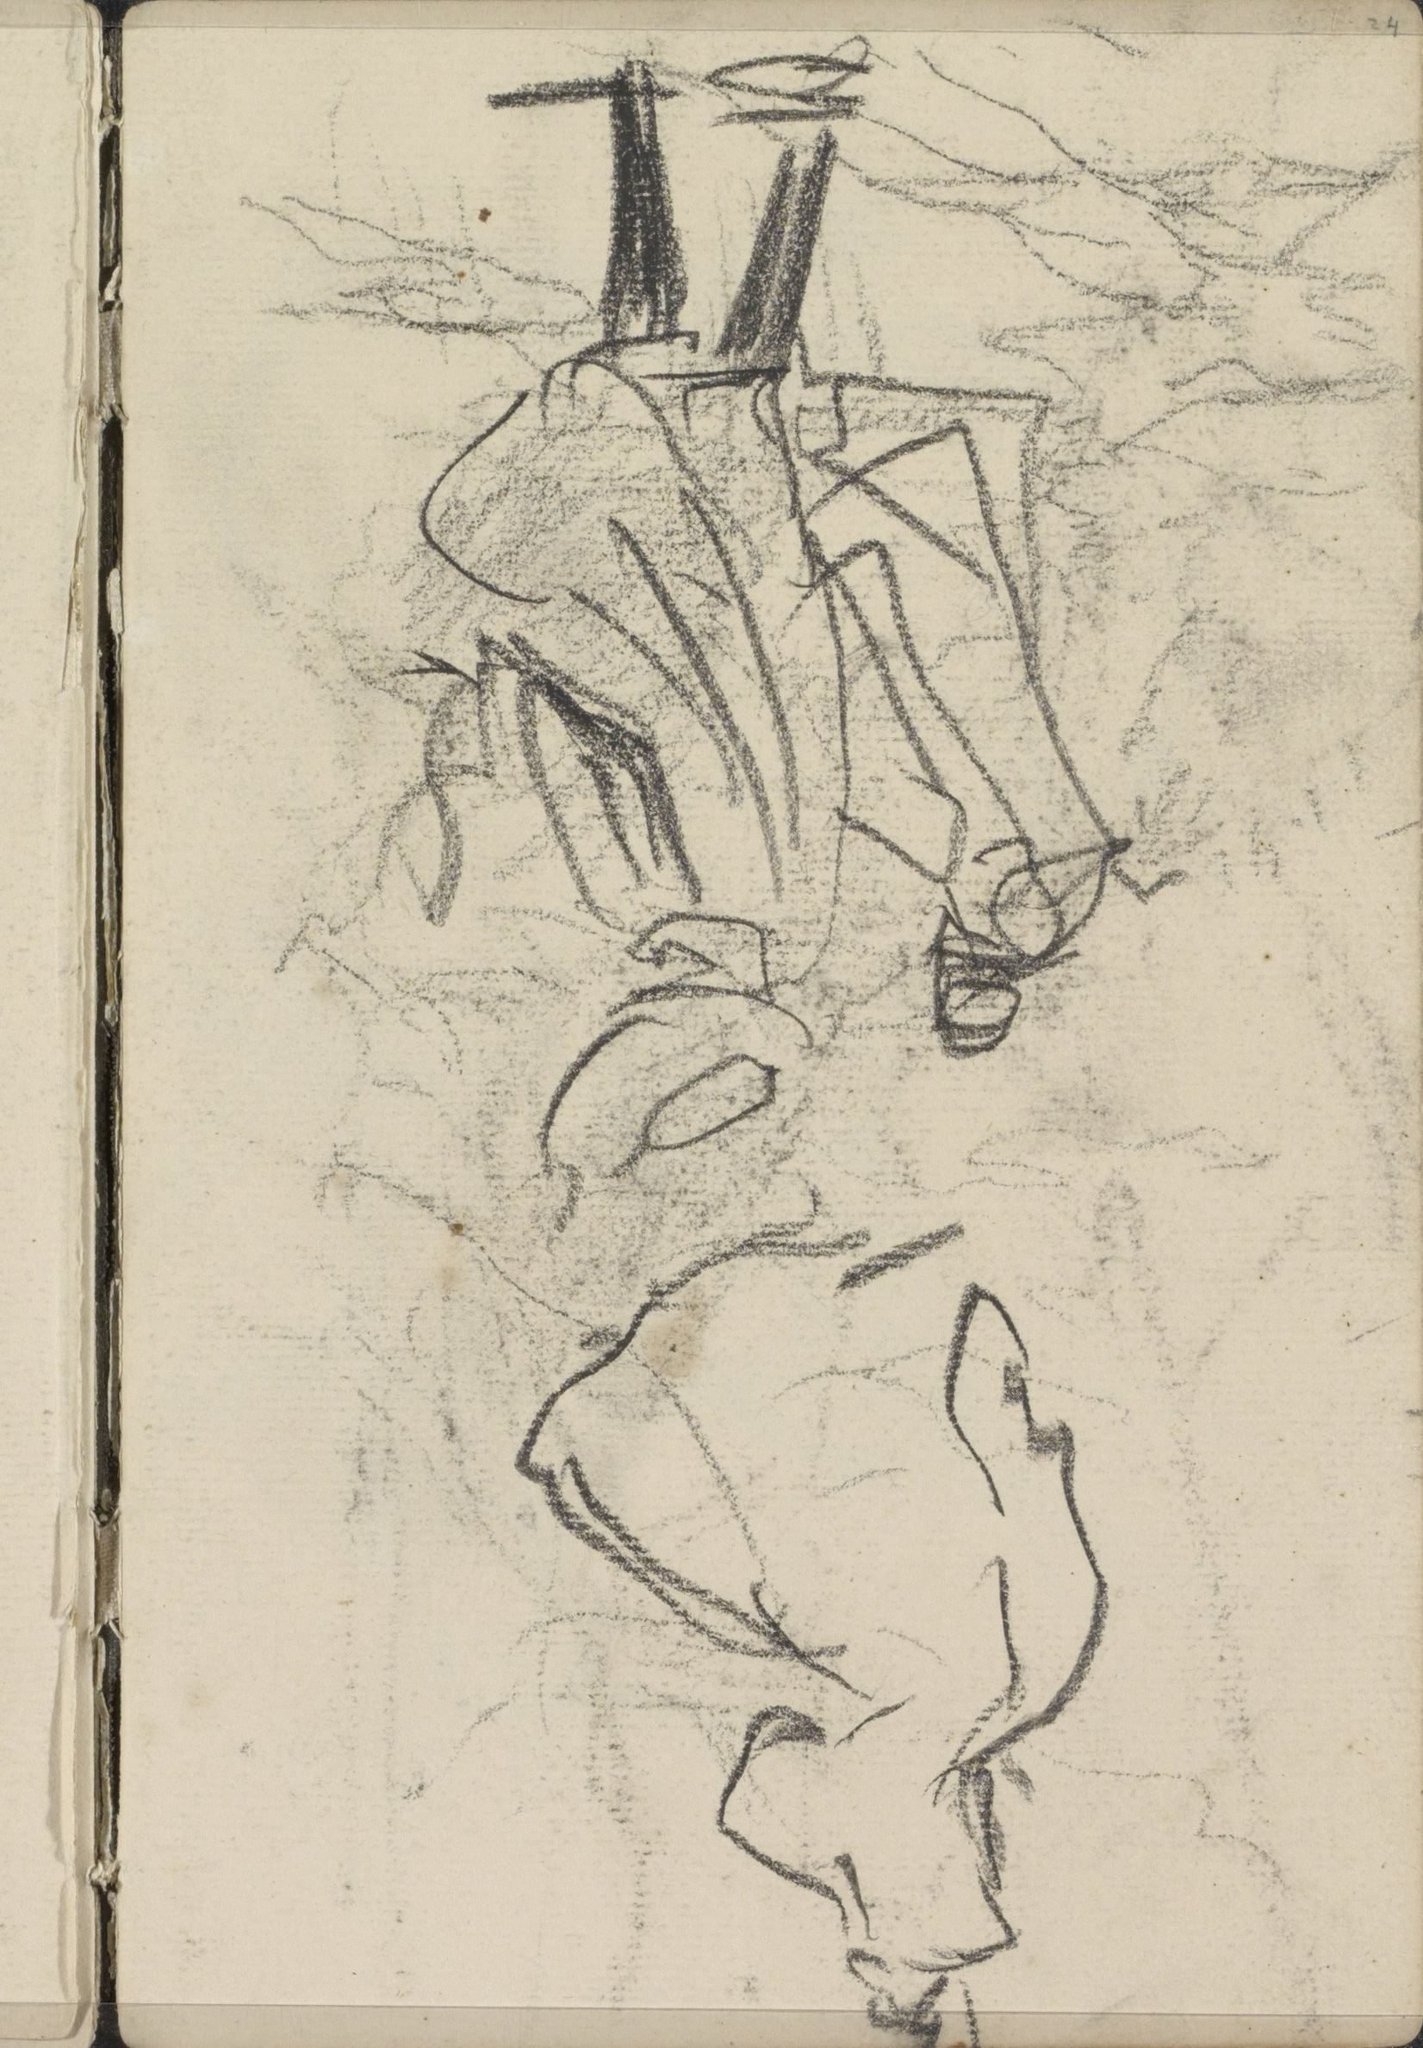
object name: sketchbook leaf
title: Studieblad met vrouwen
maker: george hendrik breitner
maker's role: draughtsman, painter, print maker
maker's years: 1857-1923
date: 1886-1923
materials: chalk, paper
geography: amsterdam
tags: adolescent, young woman, maiden, adult woman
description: Pagina 24 uit een schetsboek met 17 bladen.